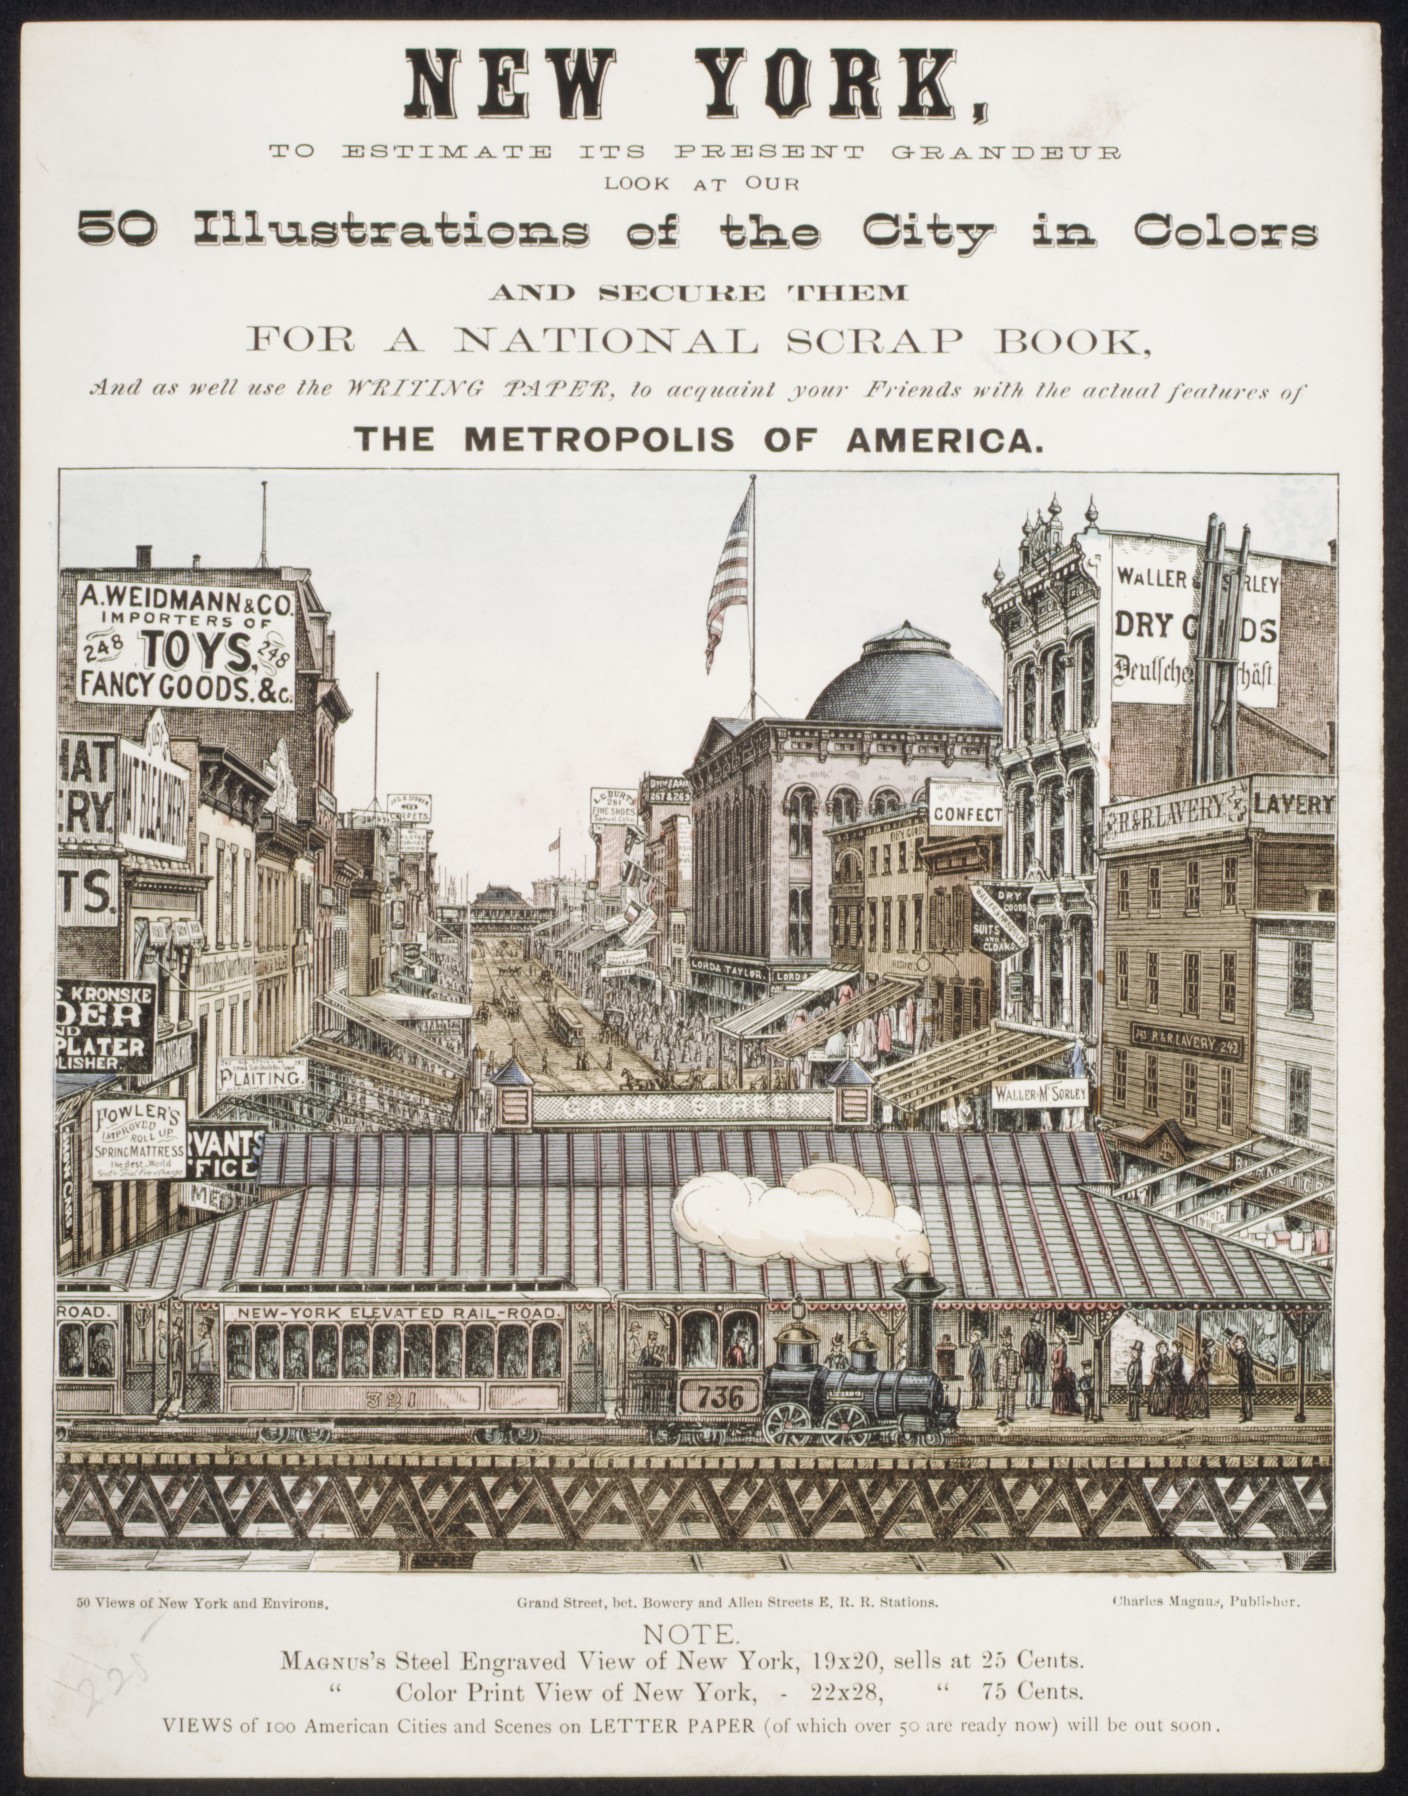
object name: print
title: New York, to Estimate its Present Grandeur Look at our 50 Illustrations of the City in Color...and acquaint your Friends with the actual features of the Metropolis of America.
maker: charles magnus & company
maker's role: publisher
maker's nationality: american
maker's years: 1854-1880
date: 1850-1900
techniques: hand coloring, engraving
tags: train stations,cities,trains,new york city